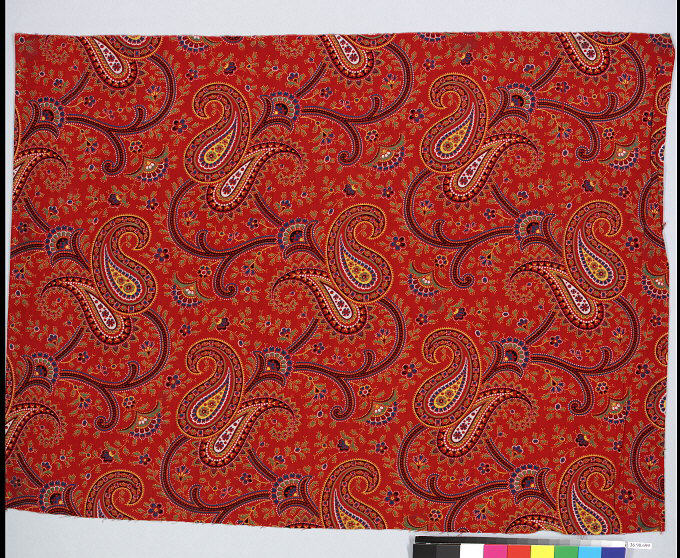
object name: piece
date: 1867-1900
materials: cotton